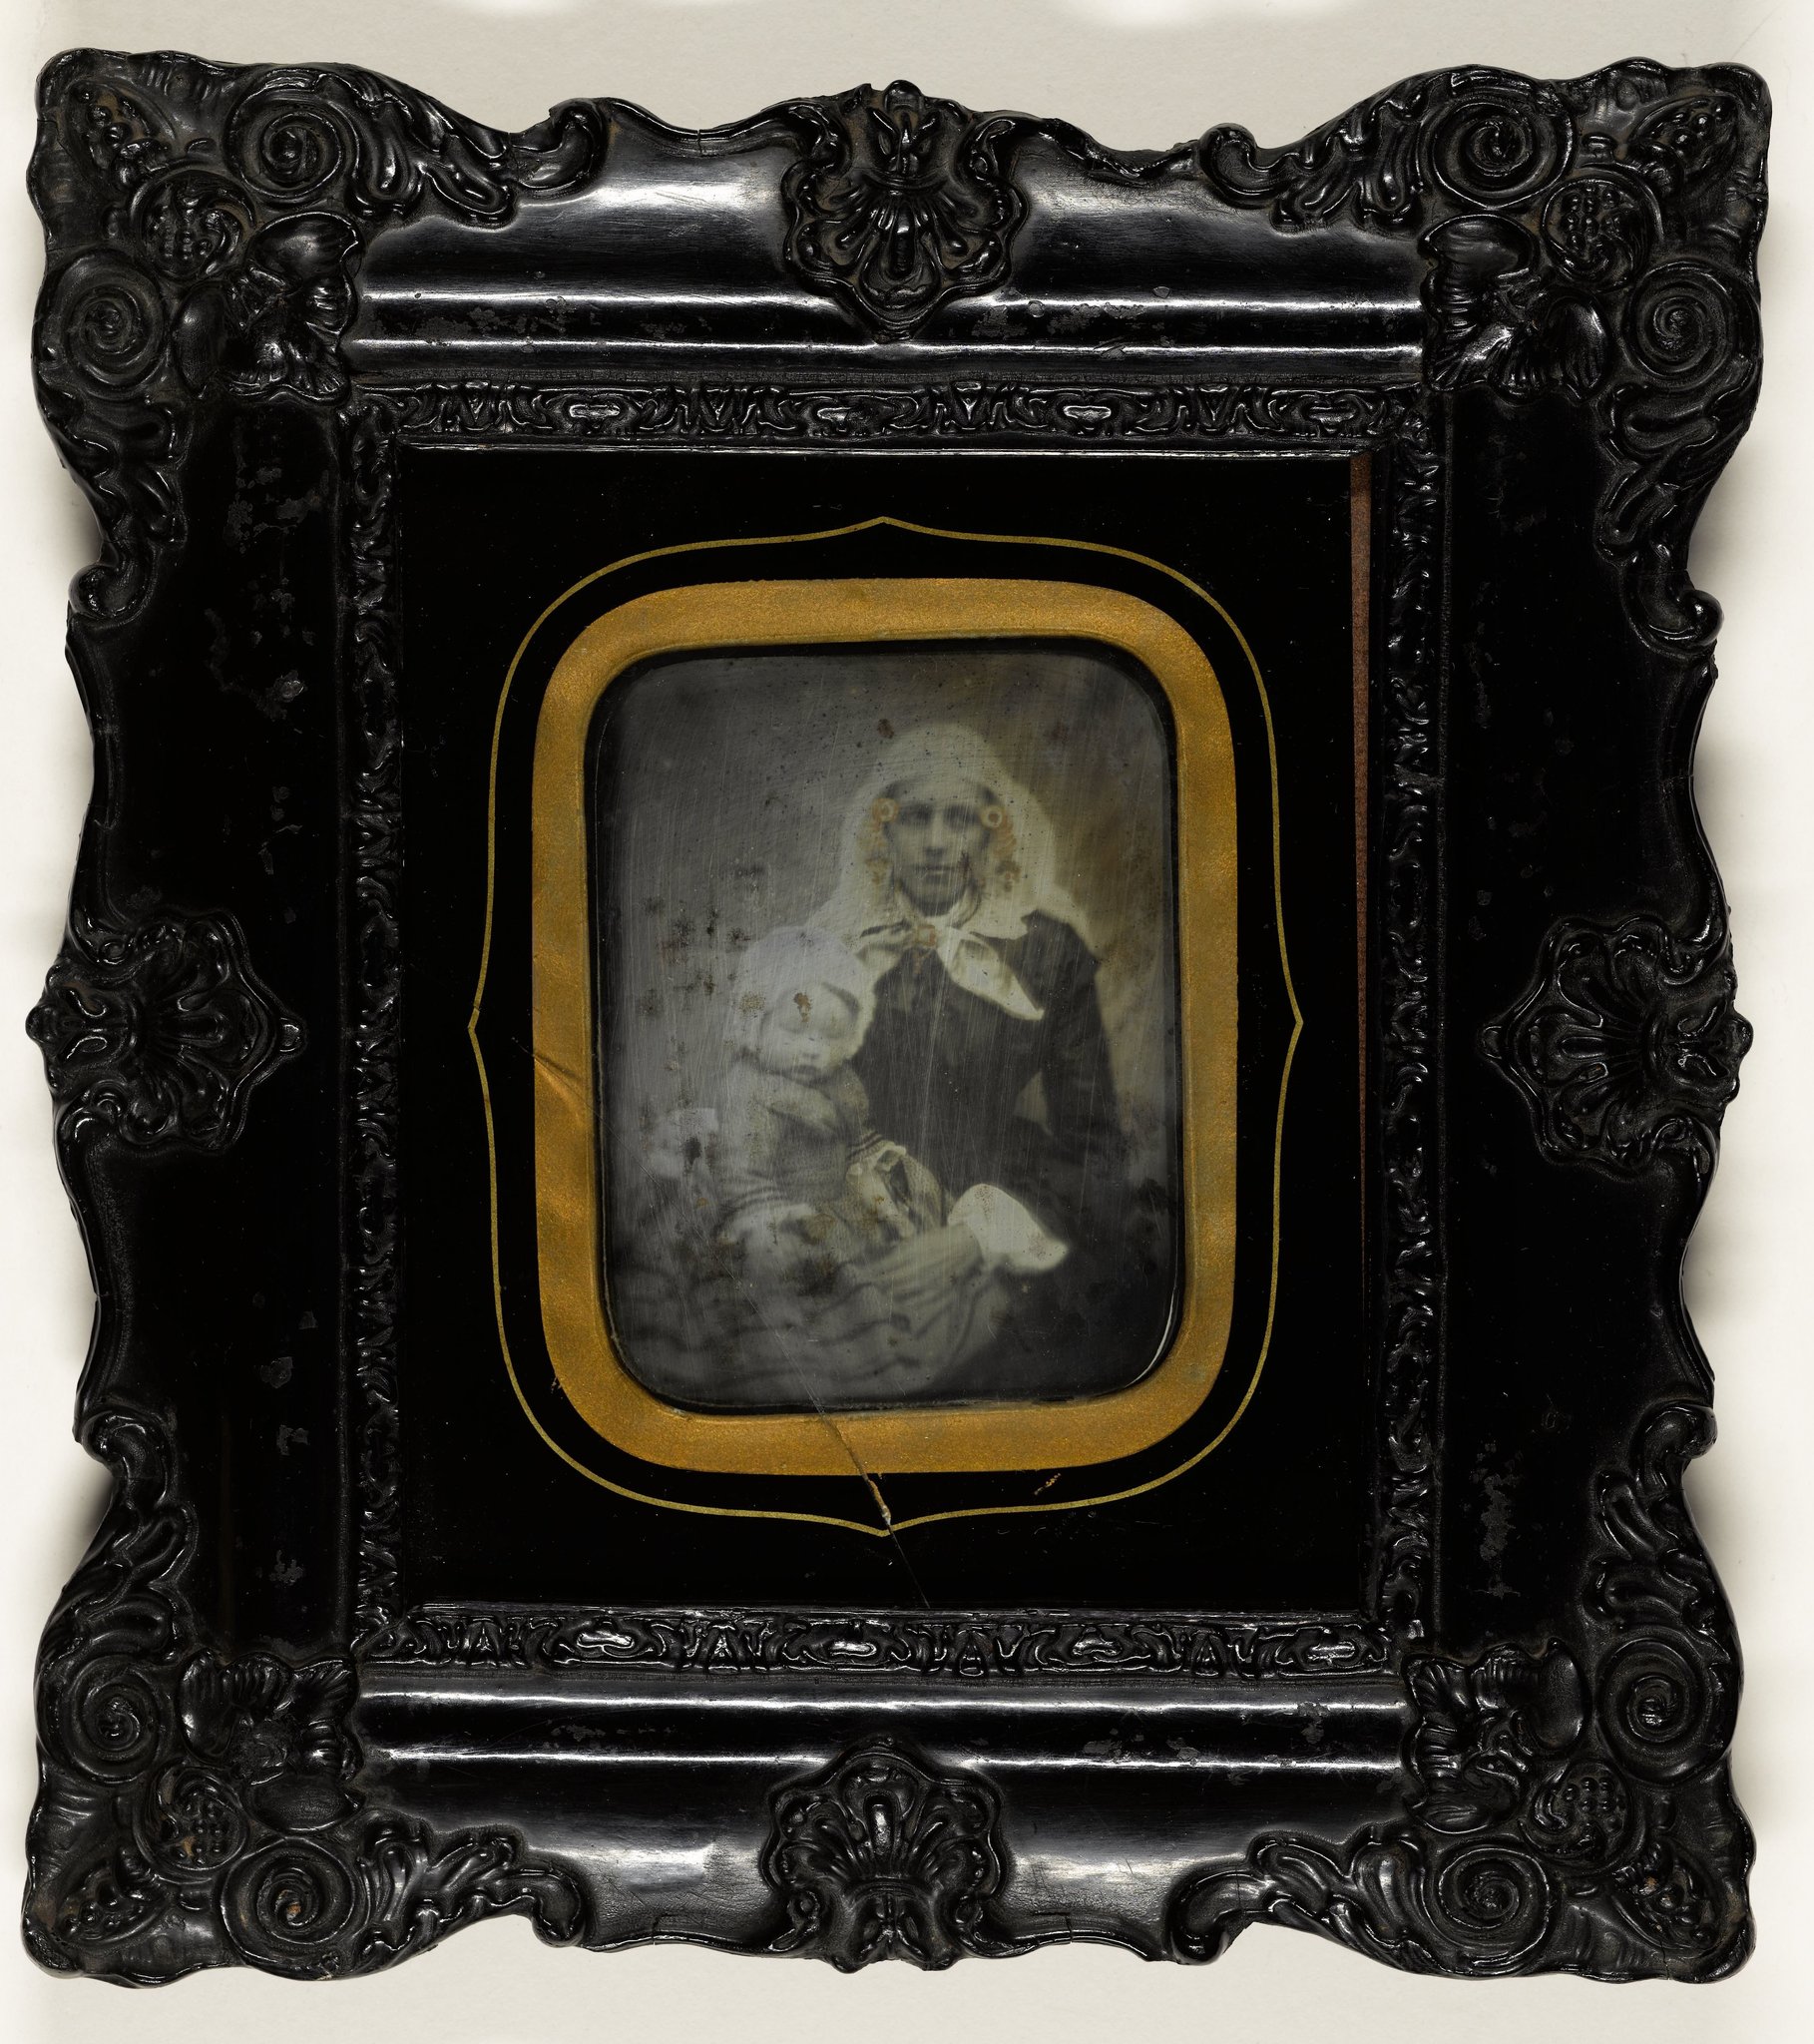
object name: frame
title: Portret van Adriana Werner-Droogendijk met haar eerste kind, Catharina Lamberdina (* 1854)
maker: Anonymous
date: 1855-1856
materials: copper, glass, paper, wood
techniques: daguerreotype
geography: netherlands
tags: historical persons - bb - woman, mother and baby or young child